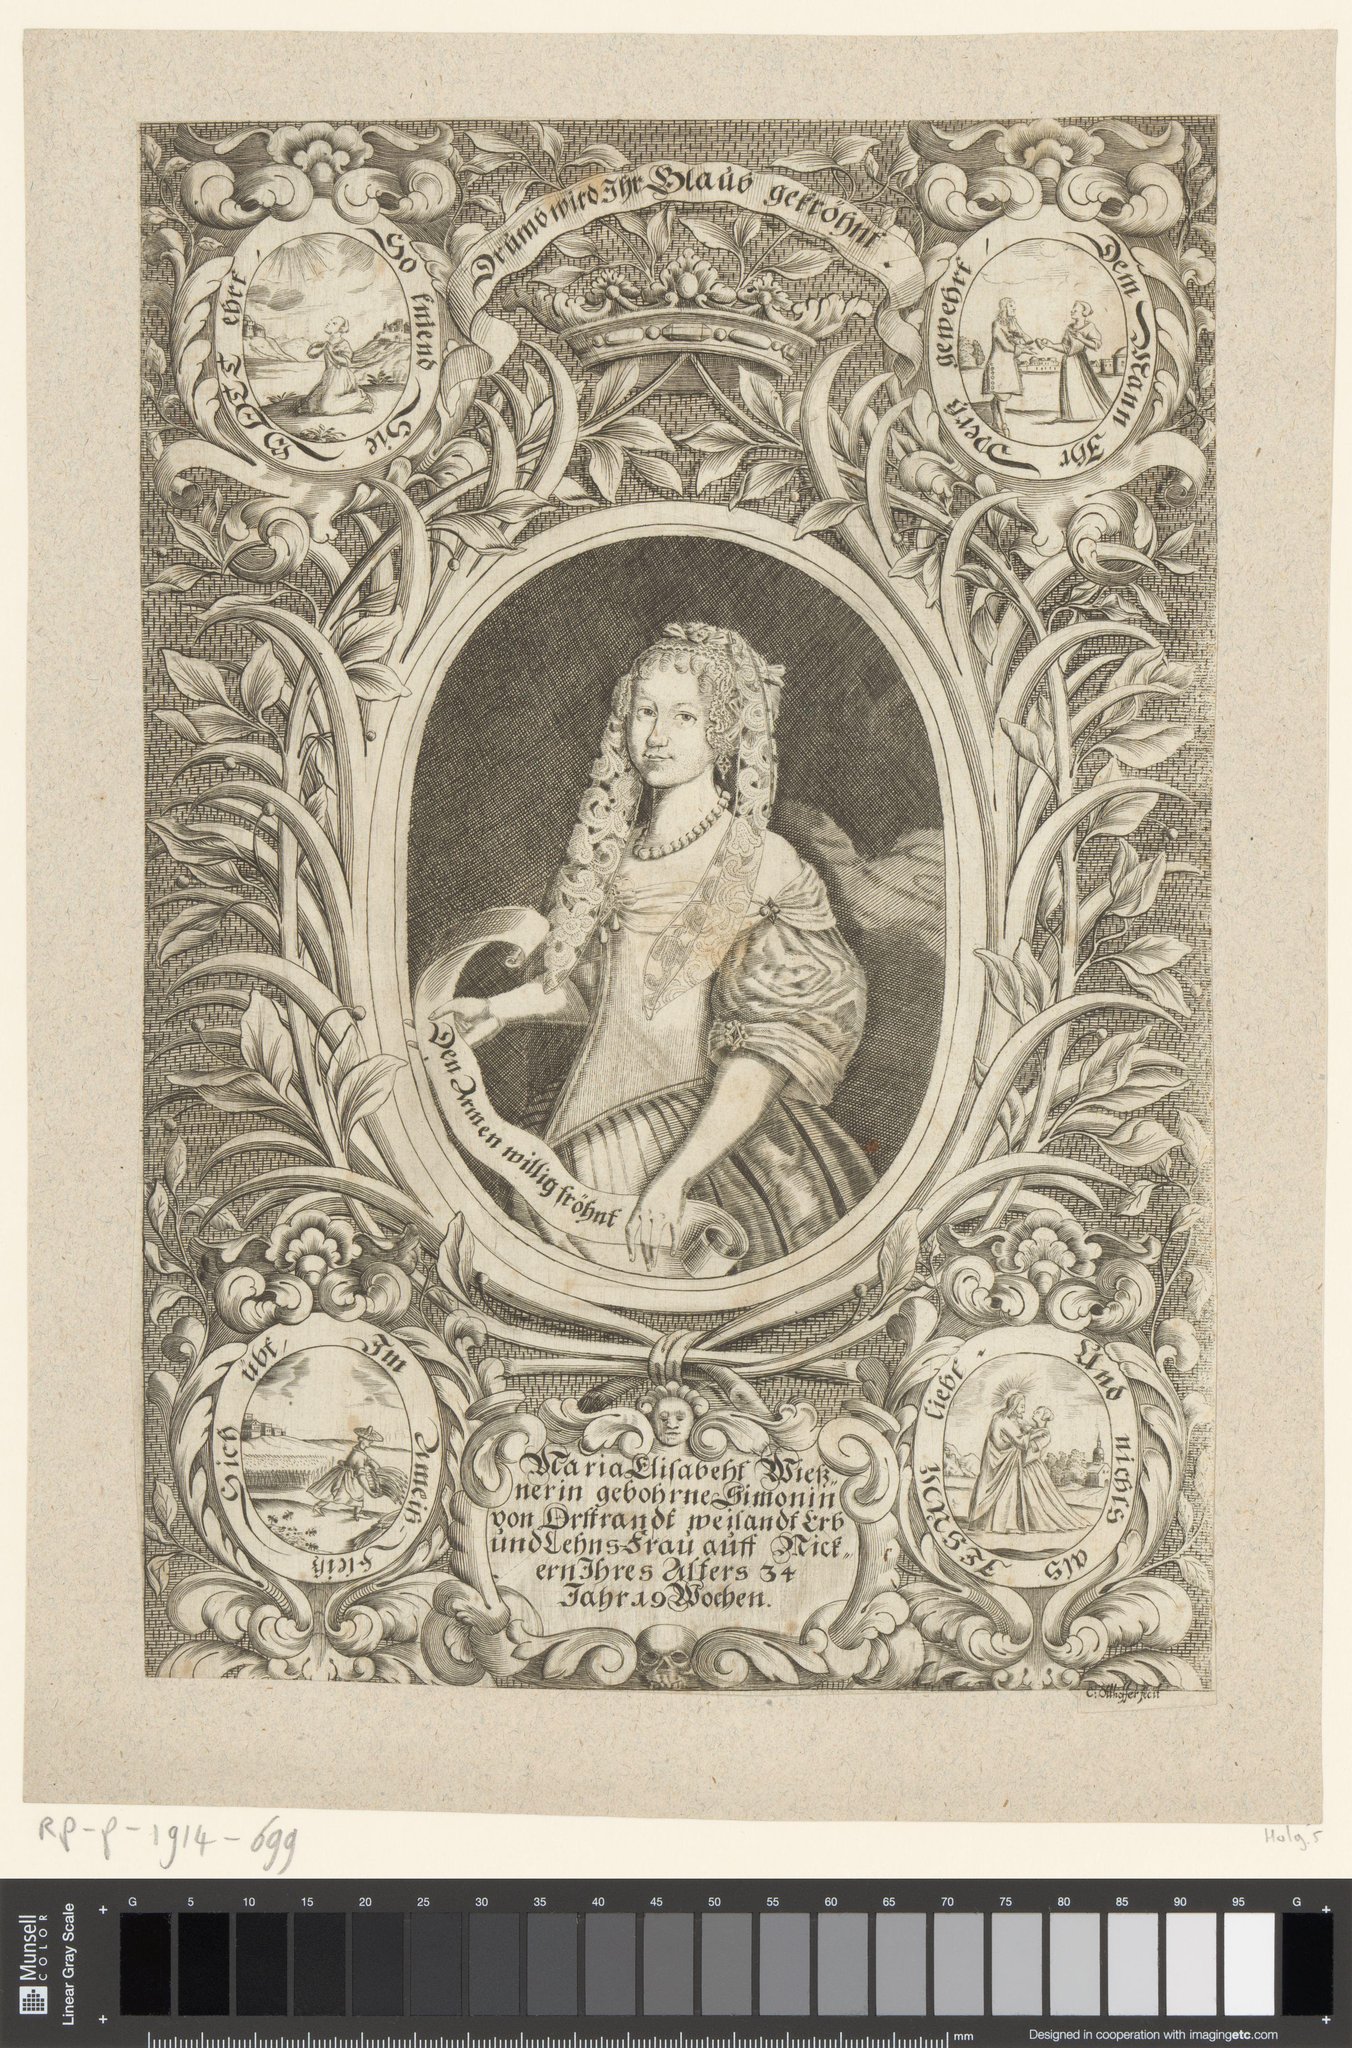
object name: print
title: Portret van Maria Elisabeth Wiessner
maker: c. ottenhofer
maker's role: print maker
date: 1650-1699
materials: paper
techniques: engraving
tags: plants (in general), harvest, crown (symbol of sovereignty), (public) prayer, historical persons - bb - woman, courtly love, christ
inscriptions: collector's mark: Lugt 2228